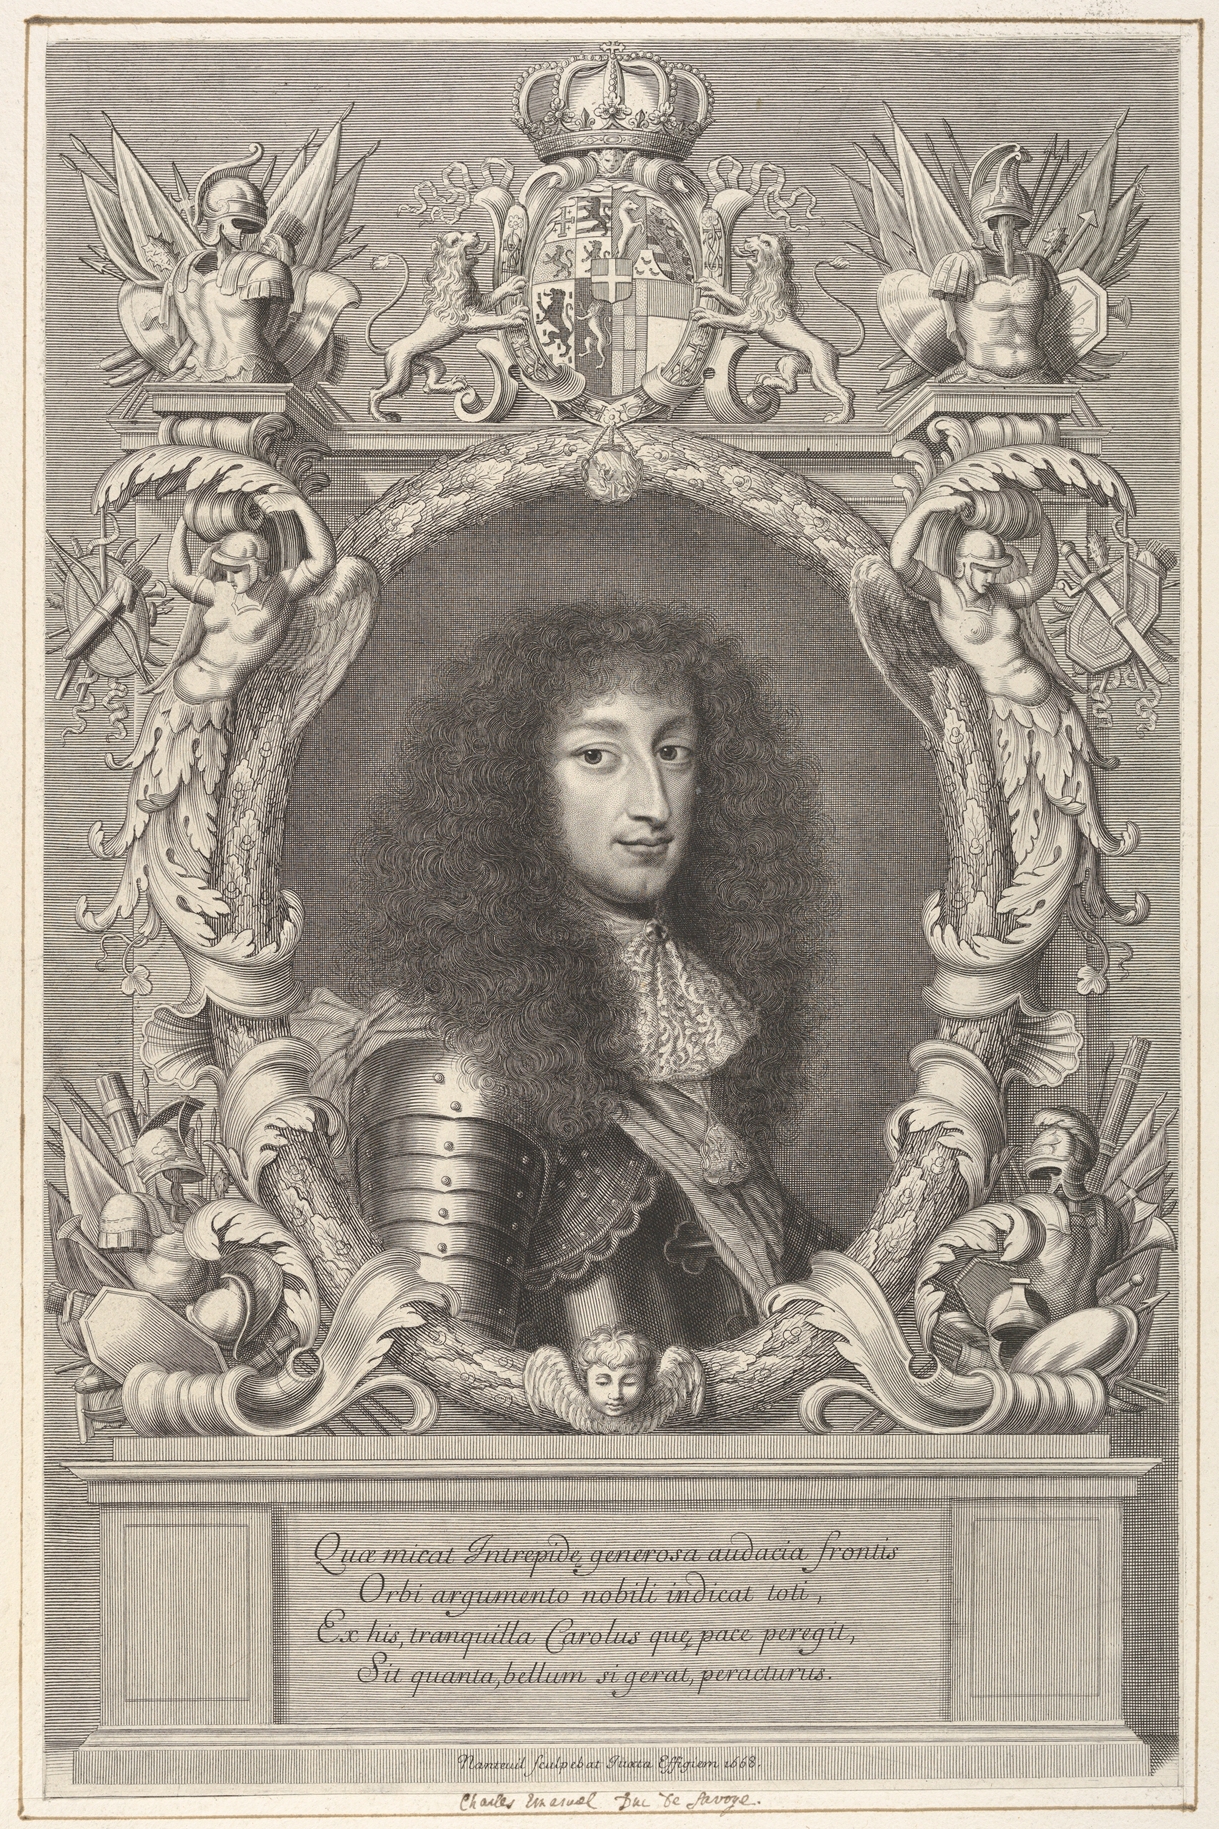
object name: print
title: Charles-Emmanuel, Duc de Savoie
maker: robert nanteuil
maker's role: artist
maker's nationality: french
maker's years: 1623-1678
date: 1668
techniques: engraving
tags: men,portraits,coat of arms